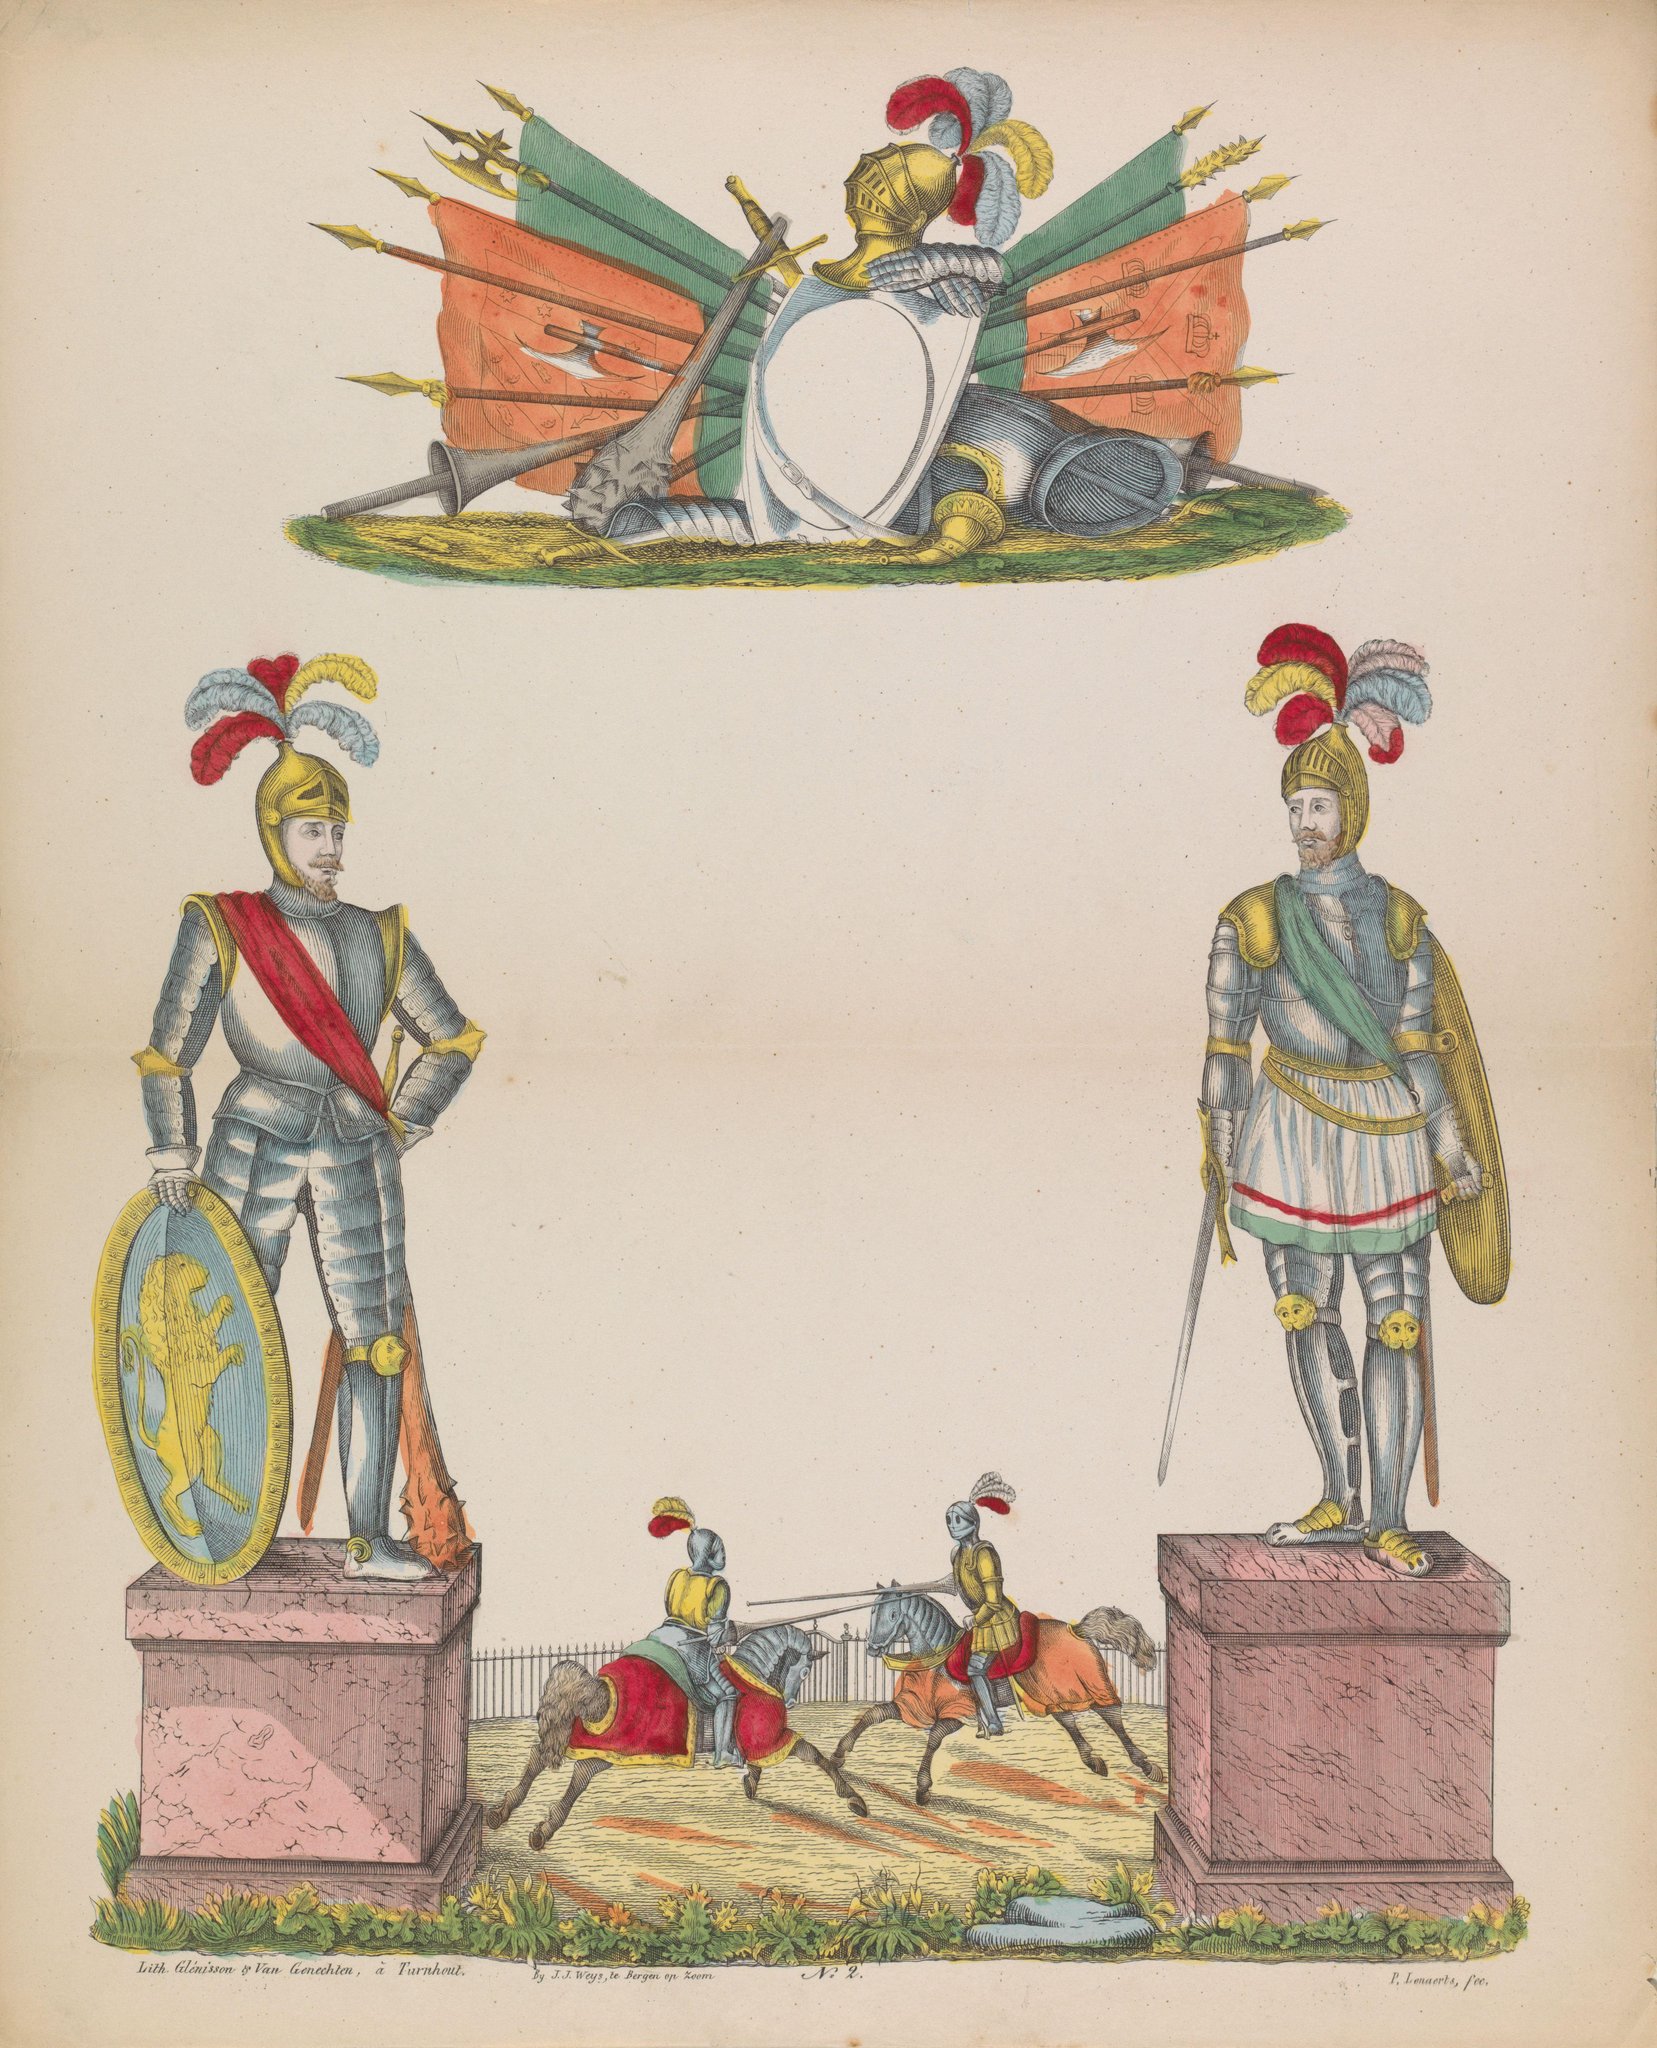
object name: popular print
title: Wensbrief met riddertoernooi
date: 1833-1856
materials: paper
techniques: colour, lithograph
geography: bergen op zoom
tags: joust, tilt, knight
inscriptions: collector's mark: Lugt 2760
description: Wensbrief met onbeschreven cartouche binnen een decoratief kader met voorstellingen van ridders, wapens, vlaggen en een riddertoernooi. Genummerd midden onder: No. 2.